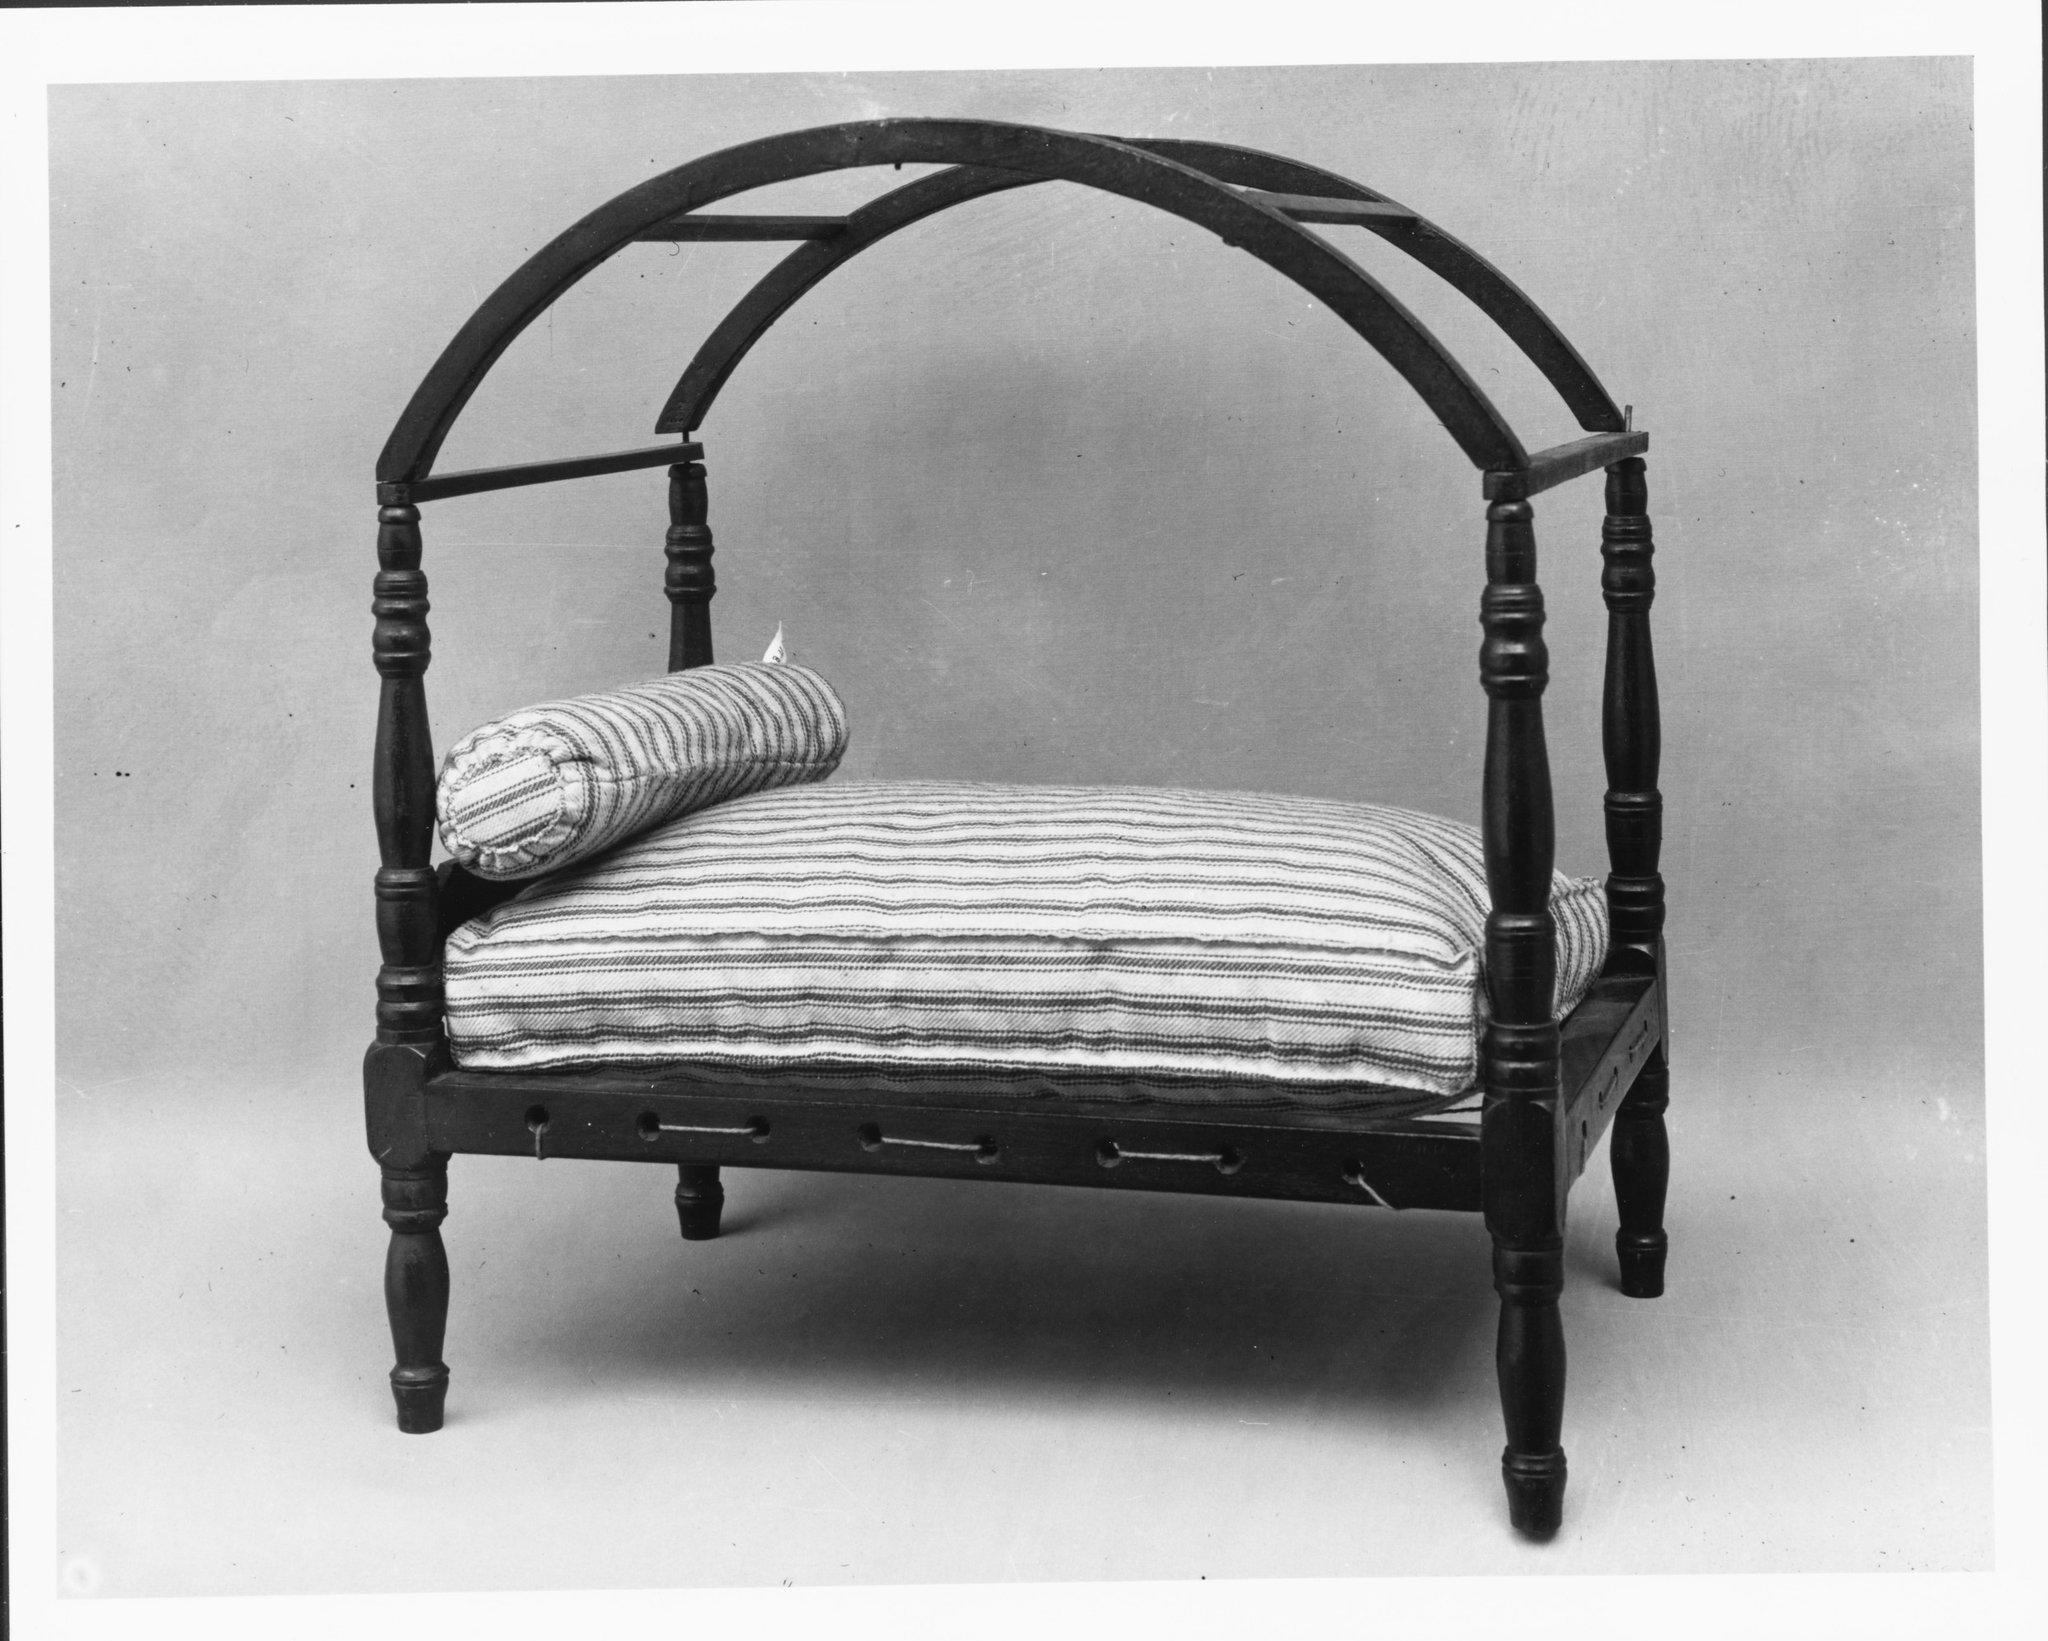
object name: bed model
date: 1770-1800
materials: wood